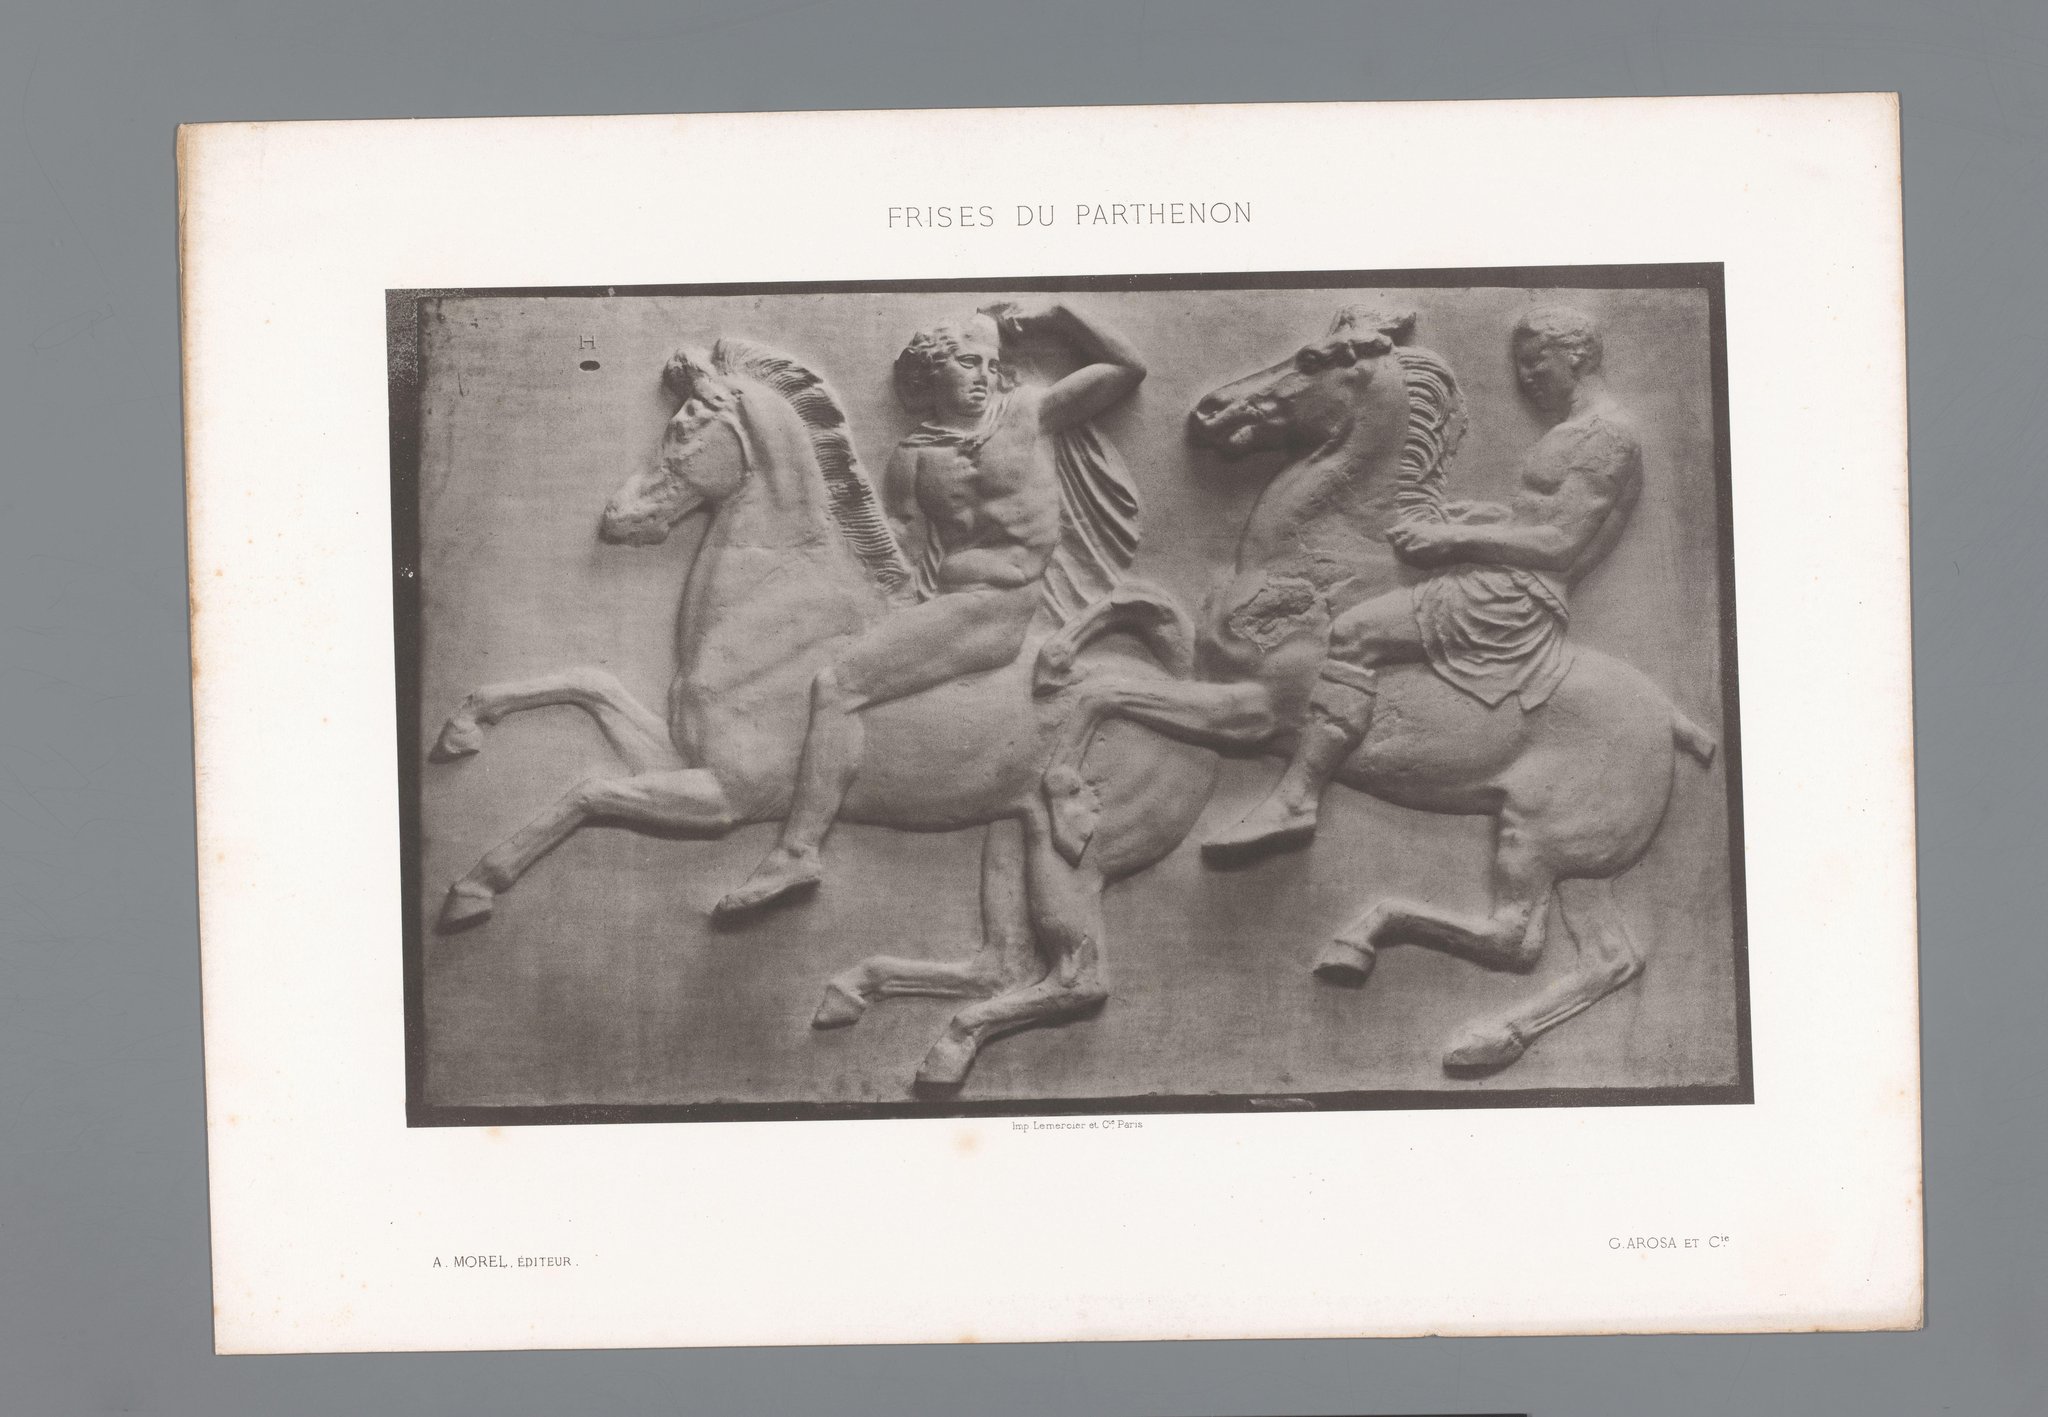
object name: photomechanical print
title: Deel van het fries van het Parthenon in Athene, afgebeeld twee ruiters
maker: a. morel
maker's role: publisher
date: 1863-1868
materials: paper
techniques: photograph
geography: paris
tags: riding a horse, ass, or mule; rider, horseman (+ two persons ~ traffic and transport), mouldings ~ architecture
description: Deze prent maakt deel uit van een omslag met 22 prenten en 3 tekstbladen.